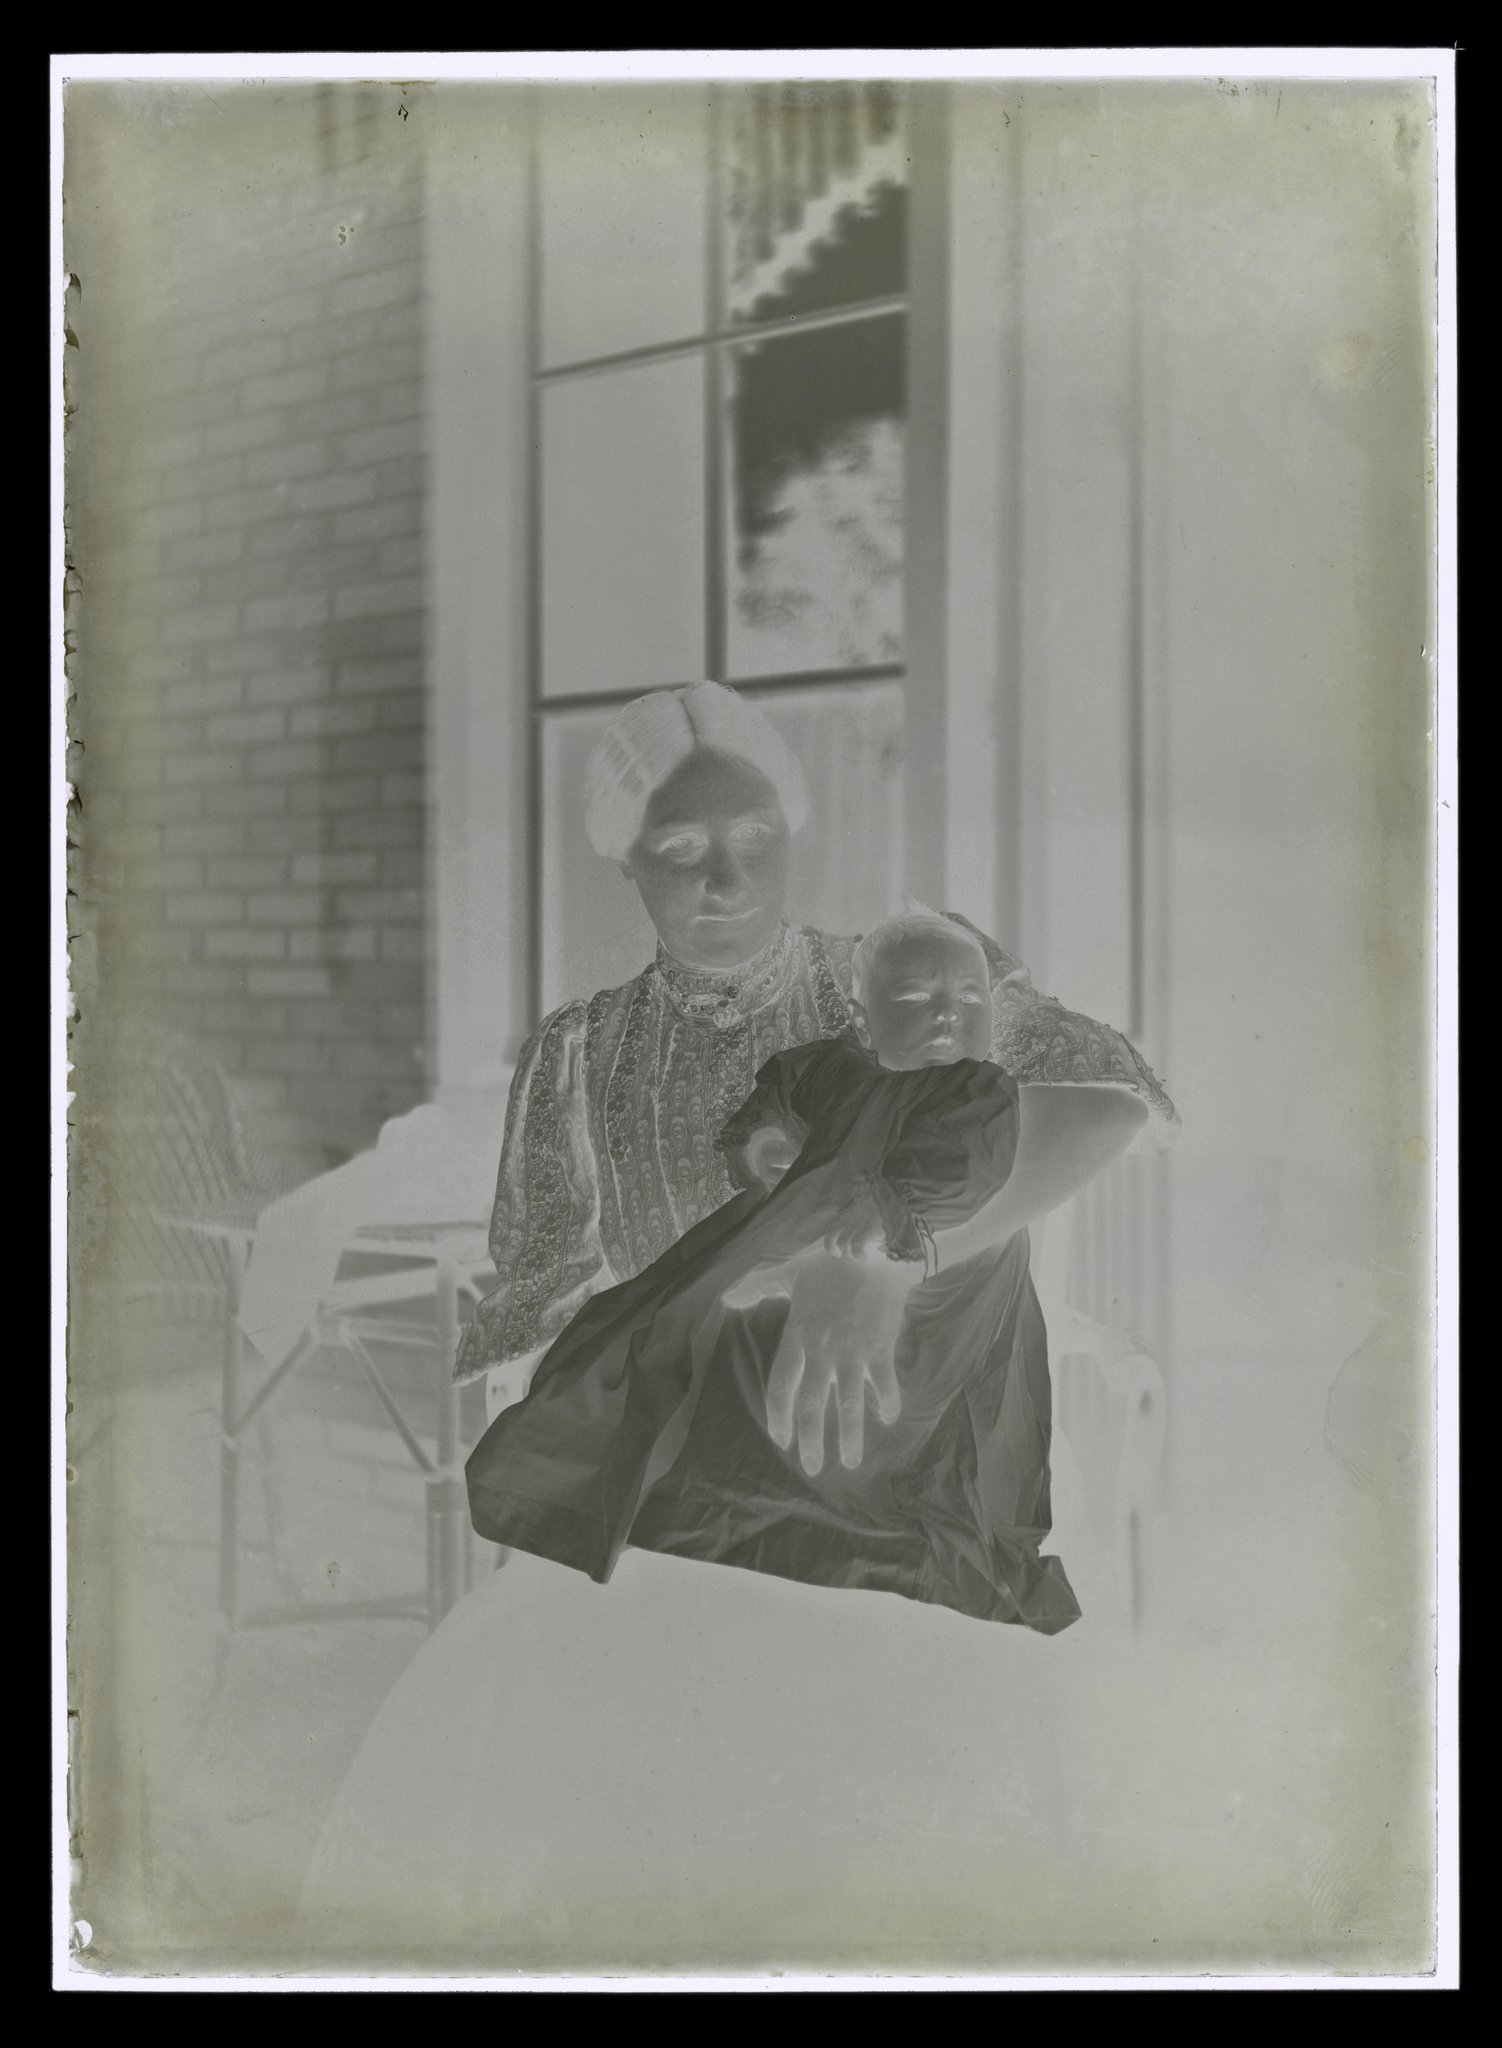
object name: glasnegatief, glasplaatnegatief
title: Elsa Diepenbrock met baby, mogelijk Thea Diepenbrock, in doopsjurk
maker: wouterus gijsbertus hondius van den broek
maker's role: amateurfotograaf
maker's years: 1867-1913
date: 1907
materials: glass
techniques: gelatin glass negative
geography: netherlands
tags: elsa diepenbrock, amsterdam, adult woman, baptism, christening gown, infant, baby